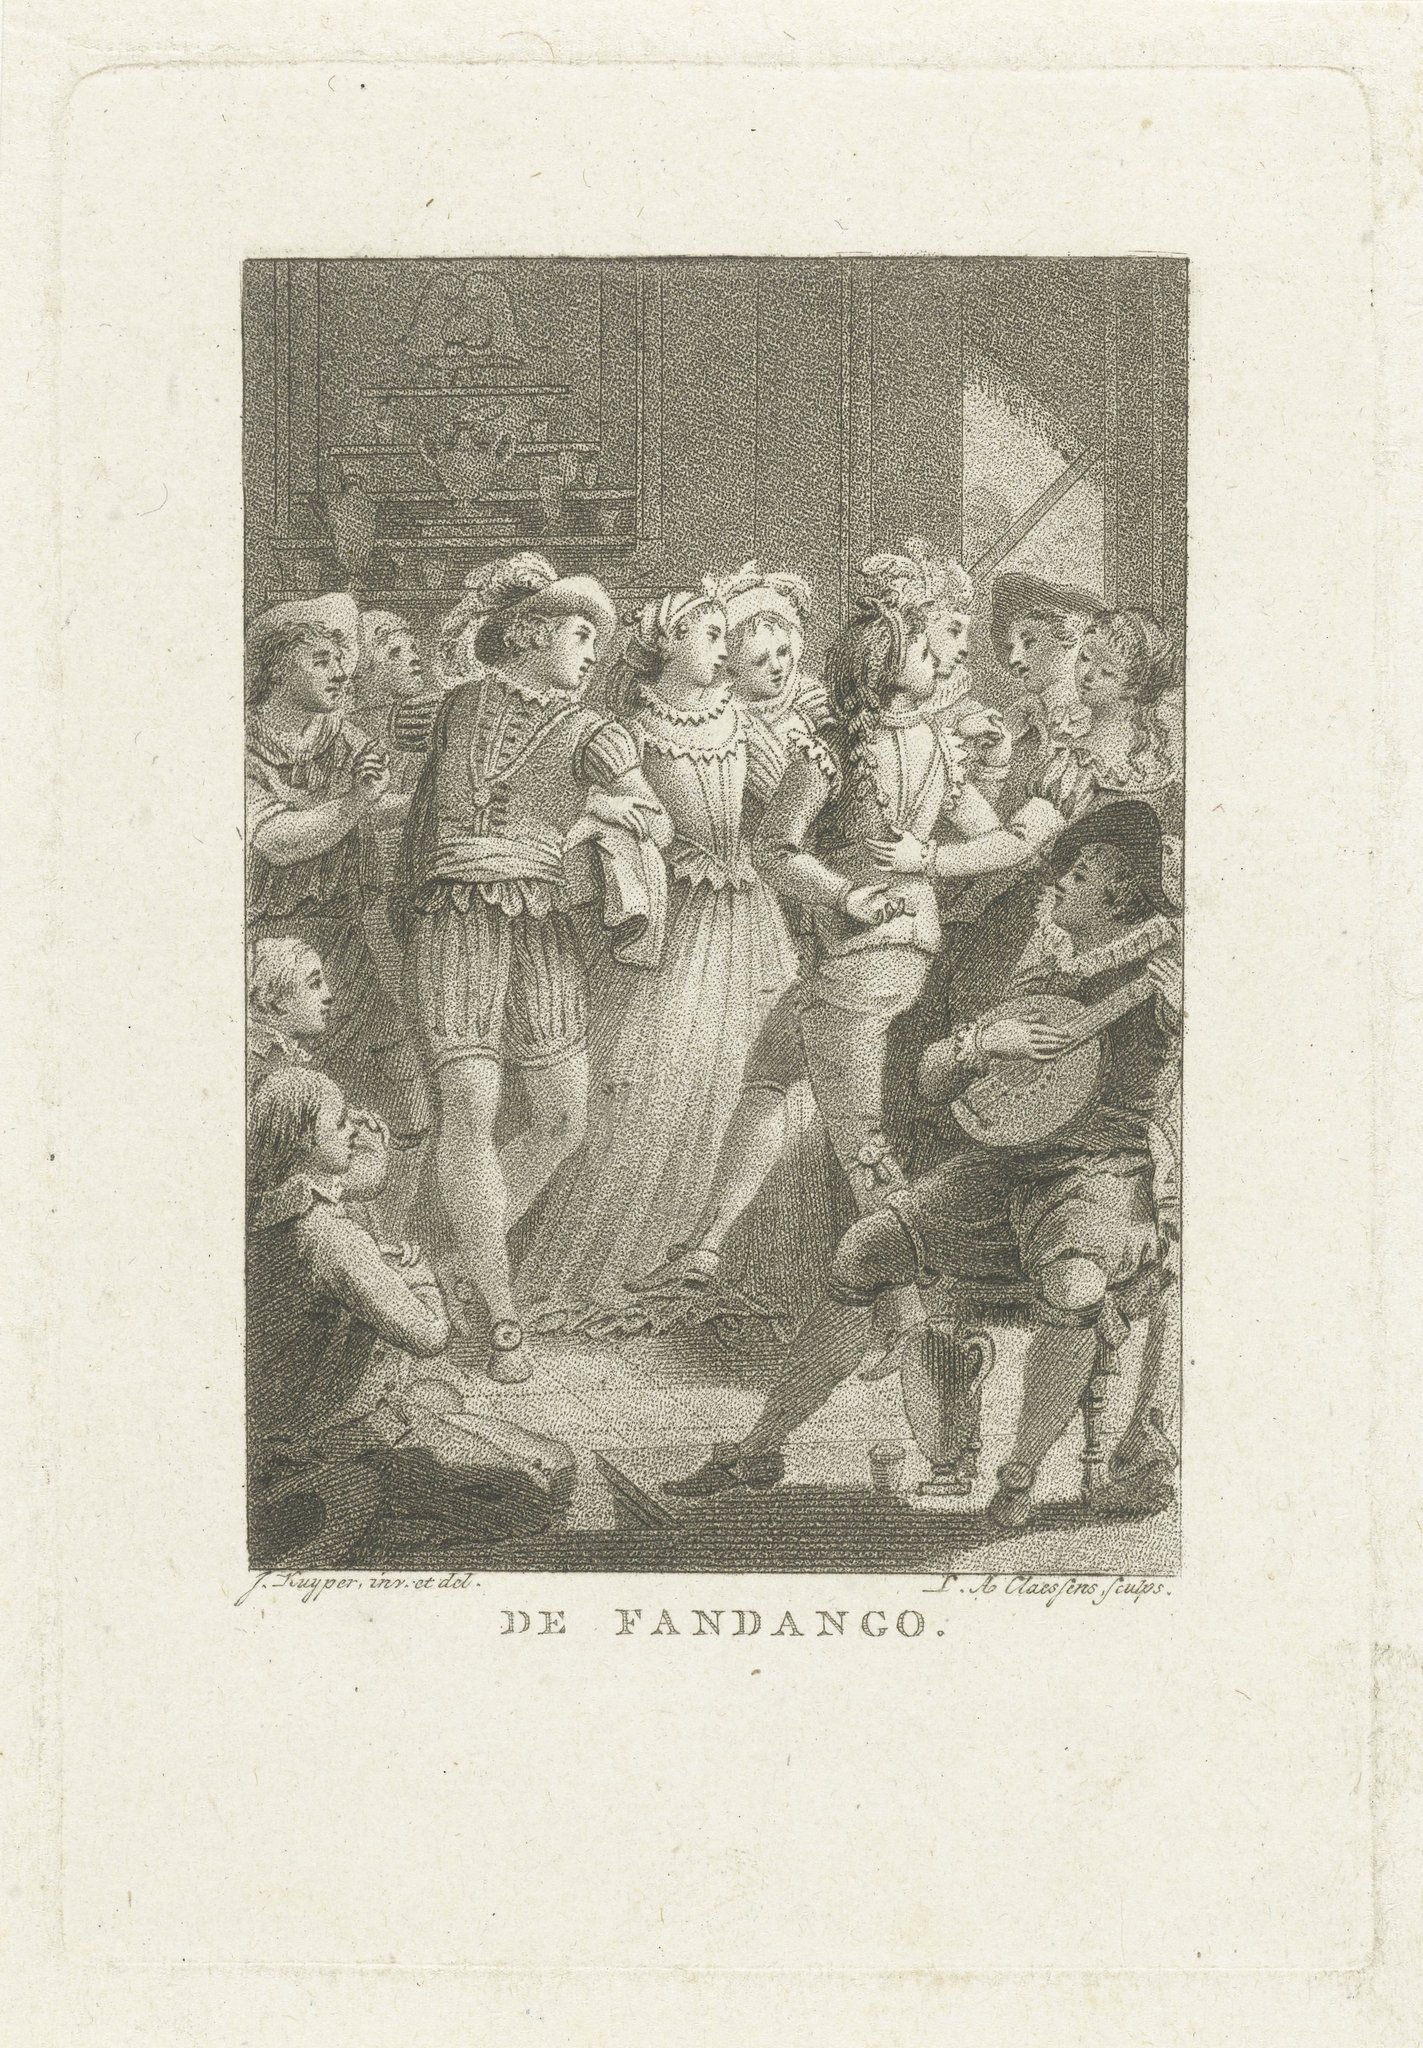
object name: print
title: Dansend gezelschap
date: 1800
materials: paper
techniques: etching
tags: more than one couple dancing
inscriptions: collector's mark: Lugt 2228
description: Illustratie voor: Ernst en Boert voor de XIXde Eeuw, of Almanach van beschaafde kundigheden voor 1801. Amsterdam: W. van Vliet en J. van der Hey, [1800].